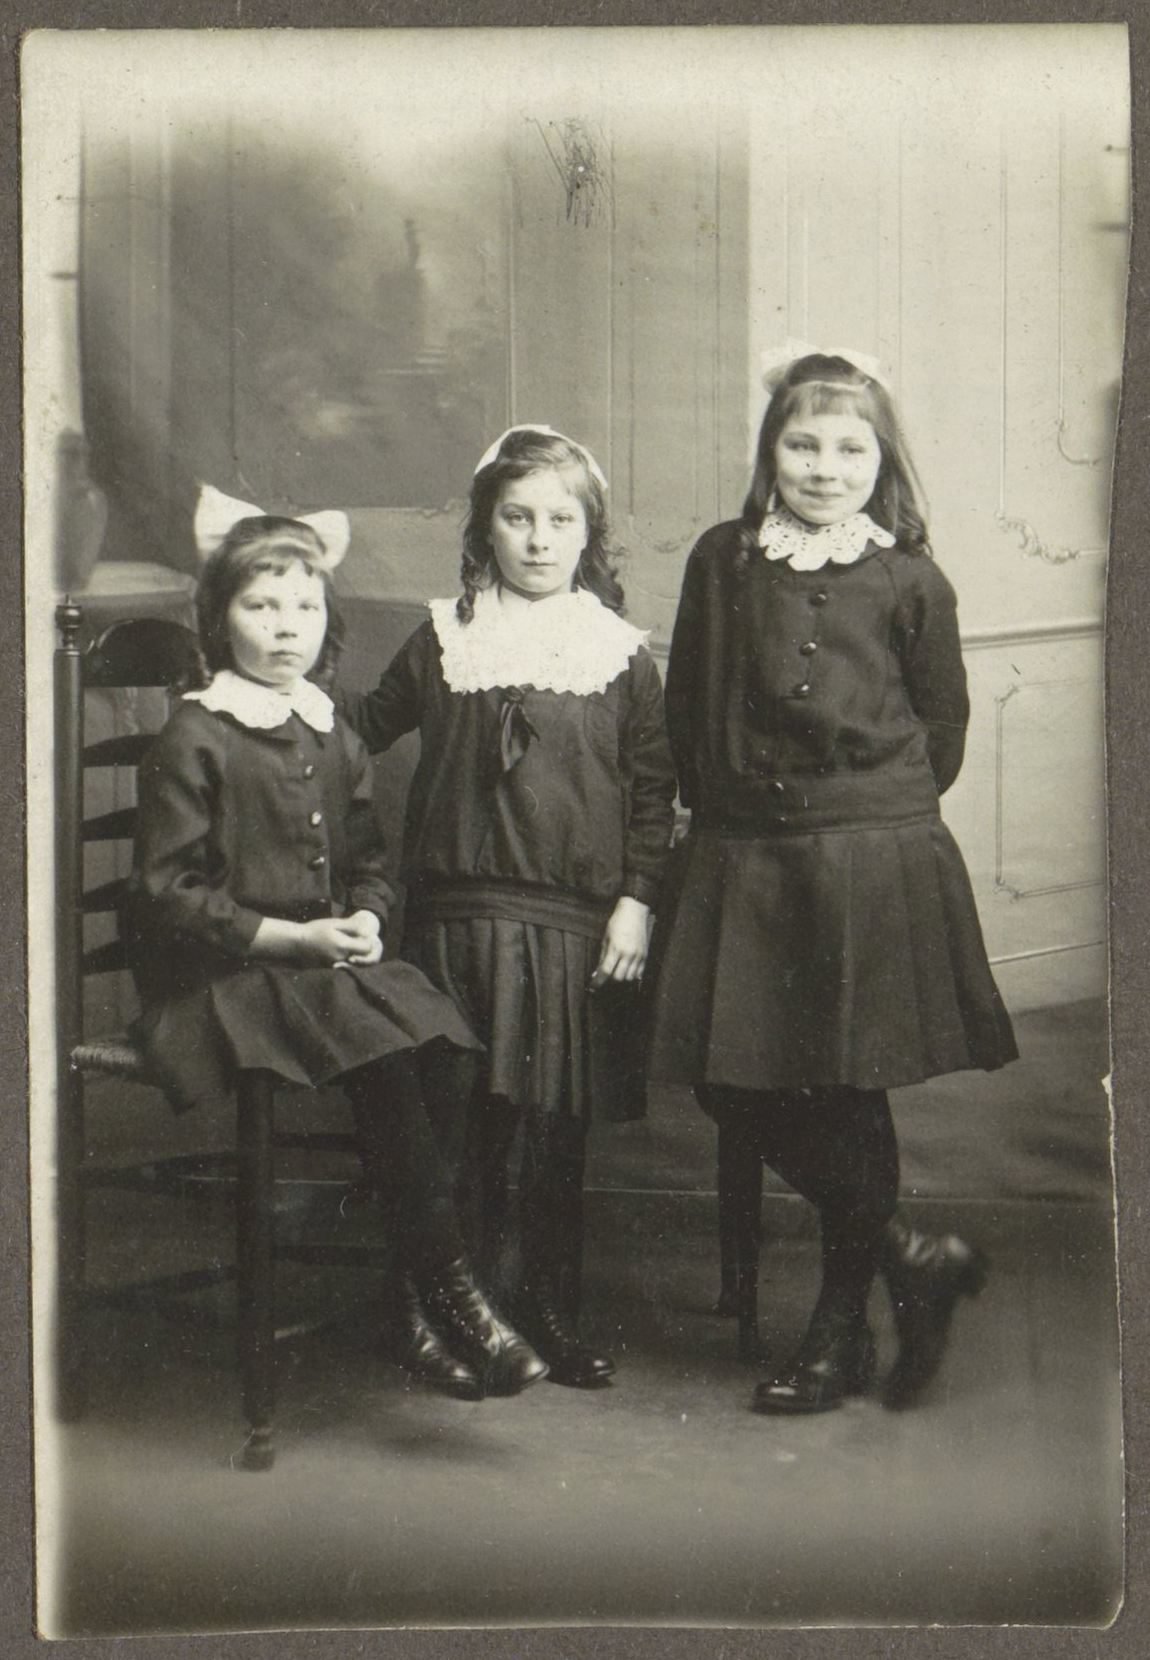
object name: album leaf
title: Groepsportret van drie meisjes, mogelijk zussen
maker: Anonymous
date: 1920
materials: cardboard, paper, photographic support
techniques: gelatin silver print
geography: netherlands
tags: studio requisites ~ photographer, historical persons, sisters (second degree family relationships), netherlands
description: Onderdeel van Fotoalbum met portretten vervaardigd door Nederlandse studio's waaronder automaatfoto's.